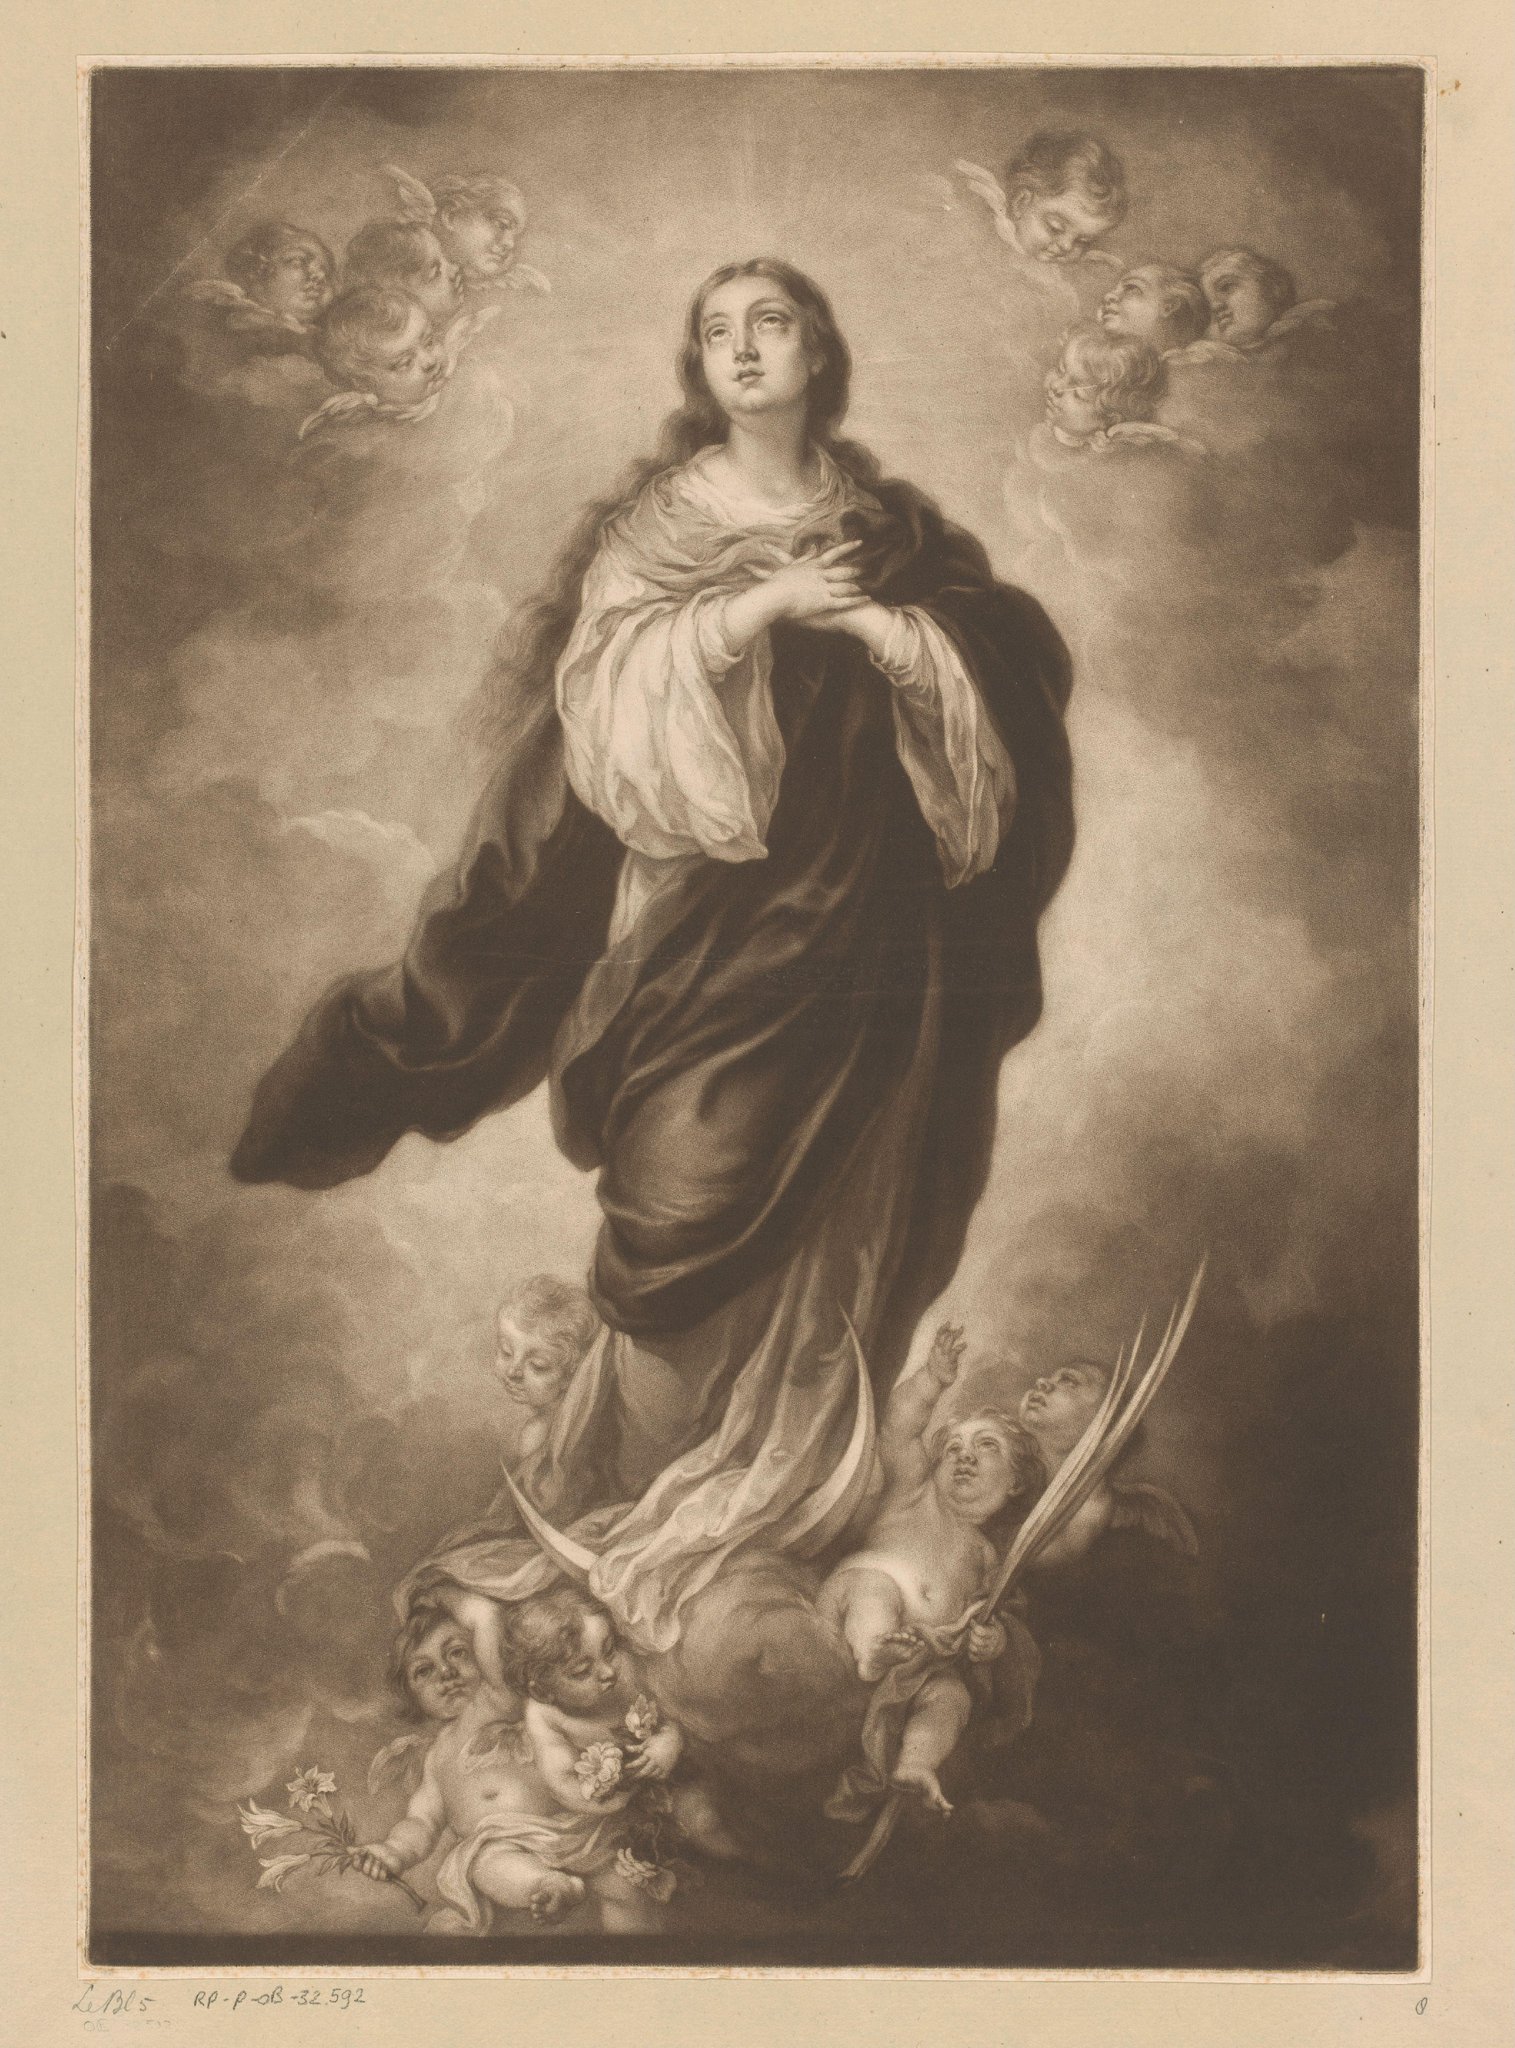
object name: print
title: Maria van de Onbevlekte Ontvangenis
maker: james mcardell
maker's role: print maker, publisher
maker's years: 1728-1765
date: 1745-1765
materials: paper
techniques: mezzotint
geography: london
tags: (immaculate) conception of mary represented symbolically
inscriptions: collector's mark: Lugt 240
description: Maria staand op een wolk met een halve maan, gedragen door putti. Zij houden een palmtak, rozen en lelies vast.